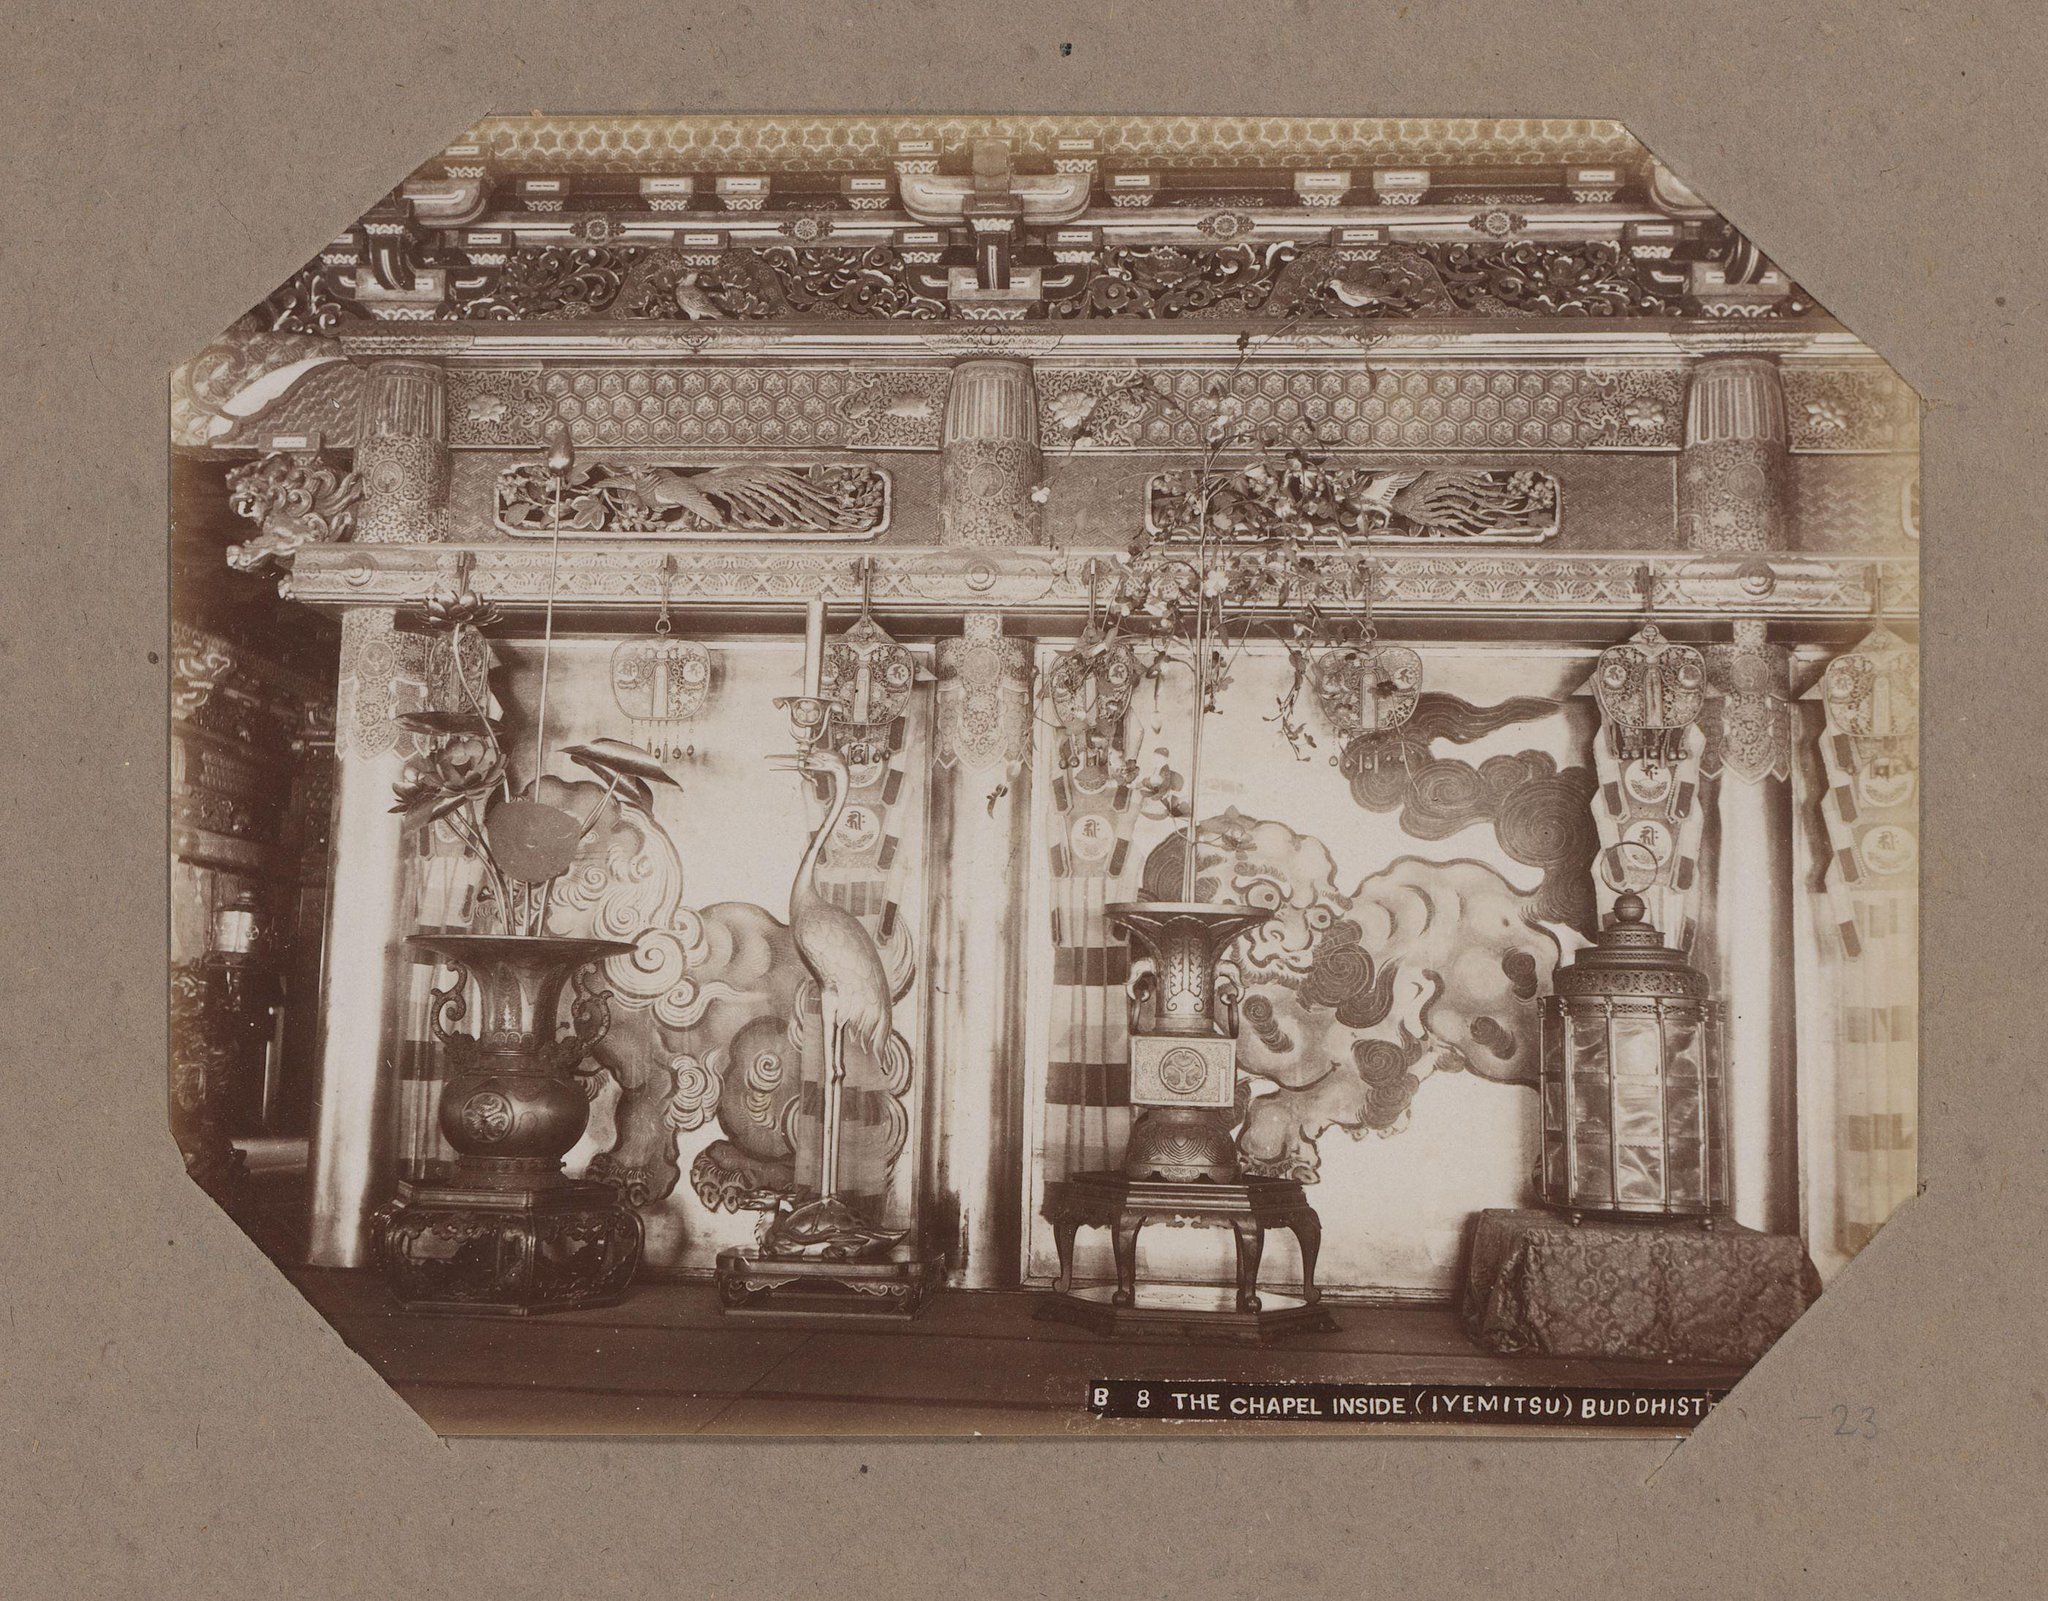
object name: photograph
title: Interieur van de gebedsruimte in de Iemitsu tempel in Nikko, Japan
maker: Anonymous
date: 1890-1903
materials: paper, photographic support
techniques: albumen print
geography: nikko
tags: temple, shrine ~ hinduism, buddhism, jainism, interior of the house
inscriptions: inscription: ‘B 8 The Chapel inside (Iyemitsu) Buddhist Temple Nikko.’